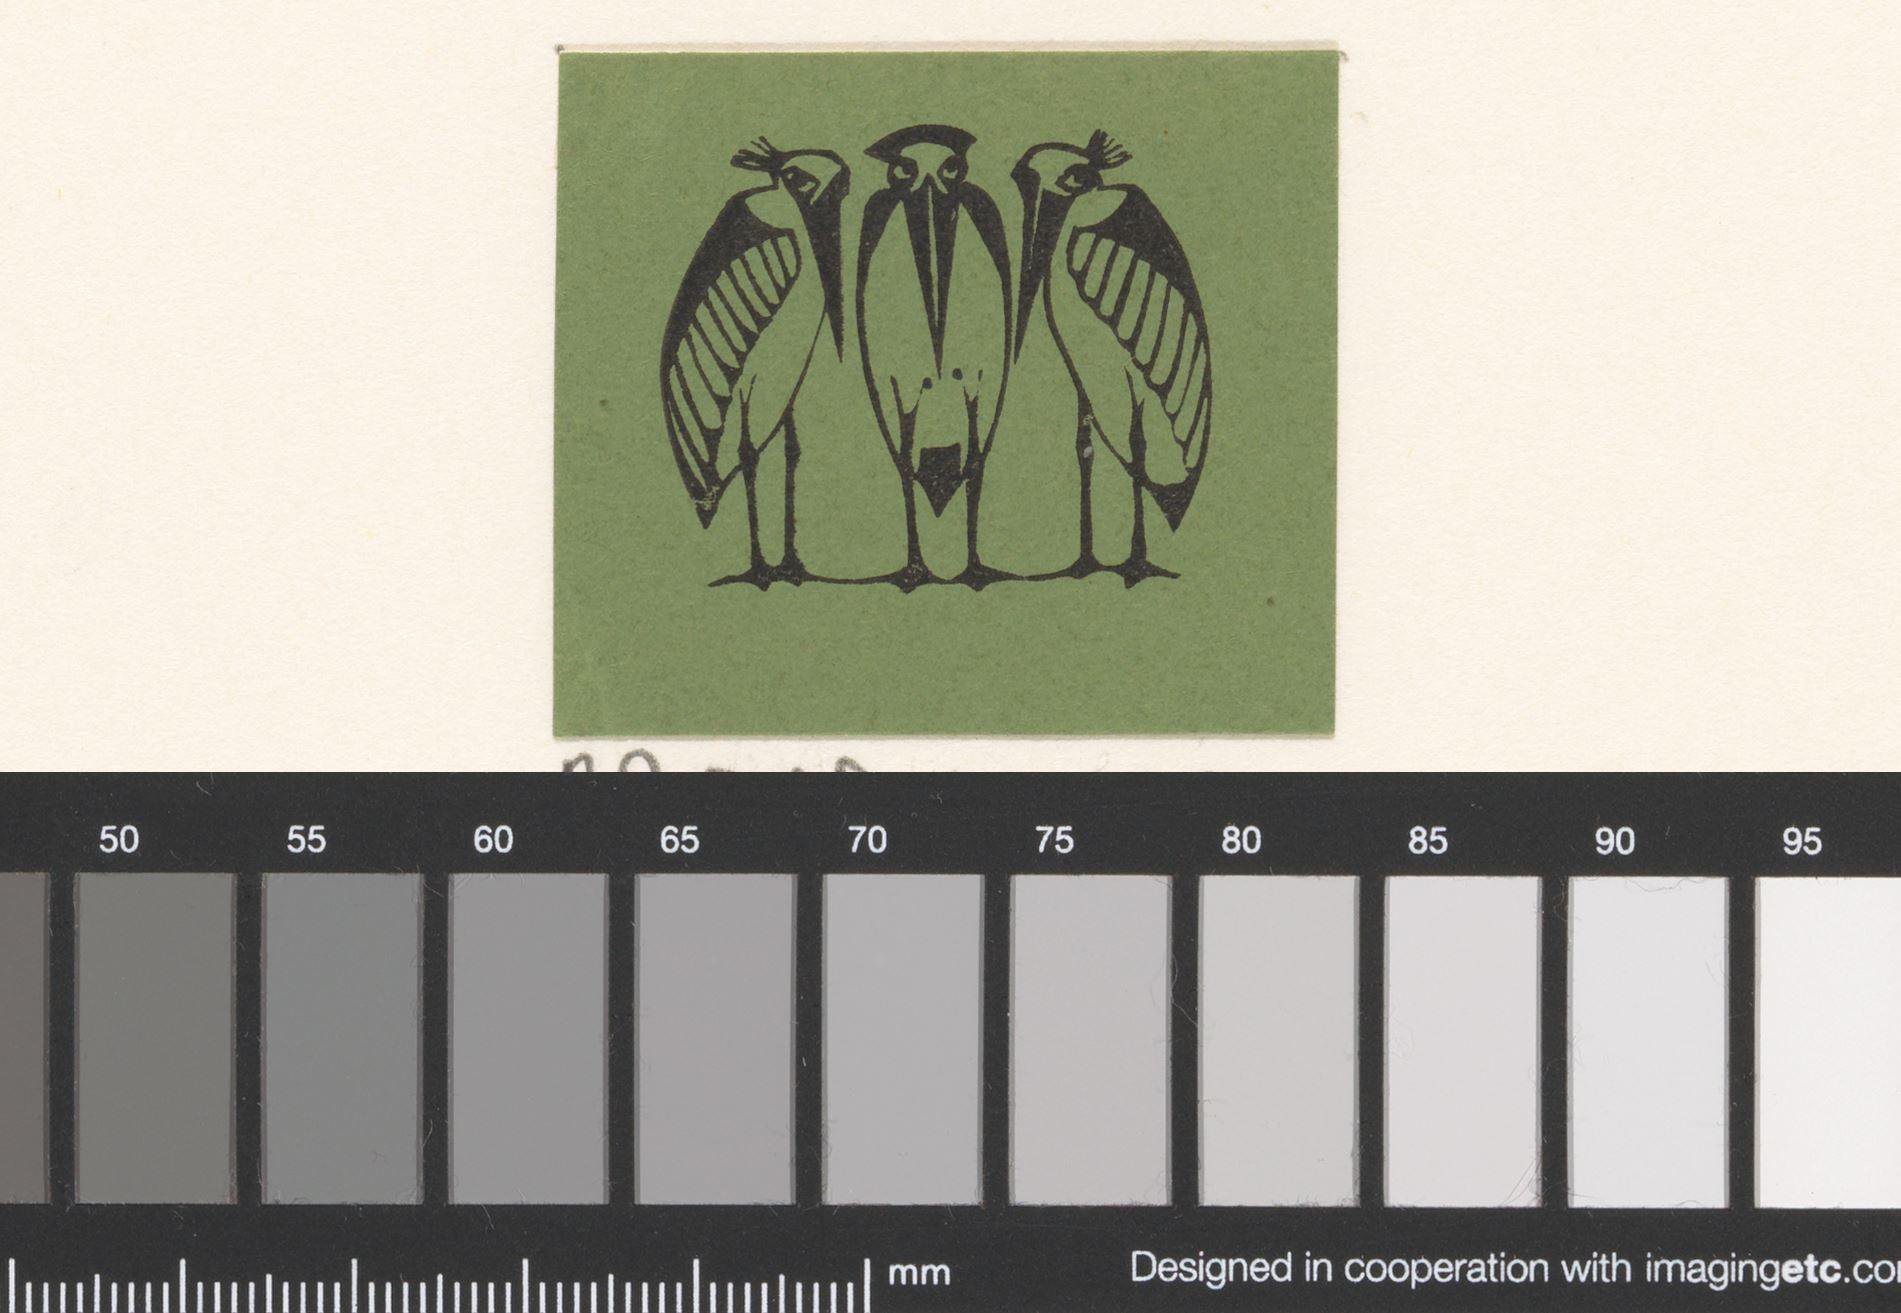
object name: print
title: Vignet met drie maraboes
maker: gerrit willem dijsselhof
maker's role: designer, draughtsman, print maker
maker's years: 1866-1924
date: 1892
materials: paper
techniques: woodcut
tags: birds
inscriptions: collector's mark: Lugt 2228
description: Gerrit Willem Dijsselhof vervaardigde zevenentwintig vignetten voor de gedichtenbundel 'Verzen' van Willem Kloos, die zou verschijnen bij de uitgeverij W. Versluys. Dit vignet is er daar één van. Hoewel de uitvoering van het boek in een ver stadium was, is het uiteindelijk nooit verschenen. De vignetten zijn later wel voor diverse andere doeleinden gebruikt.